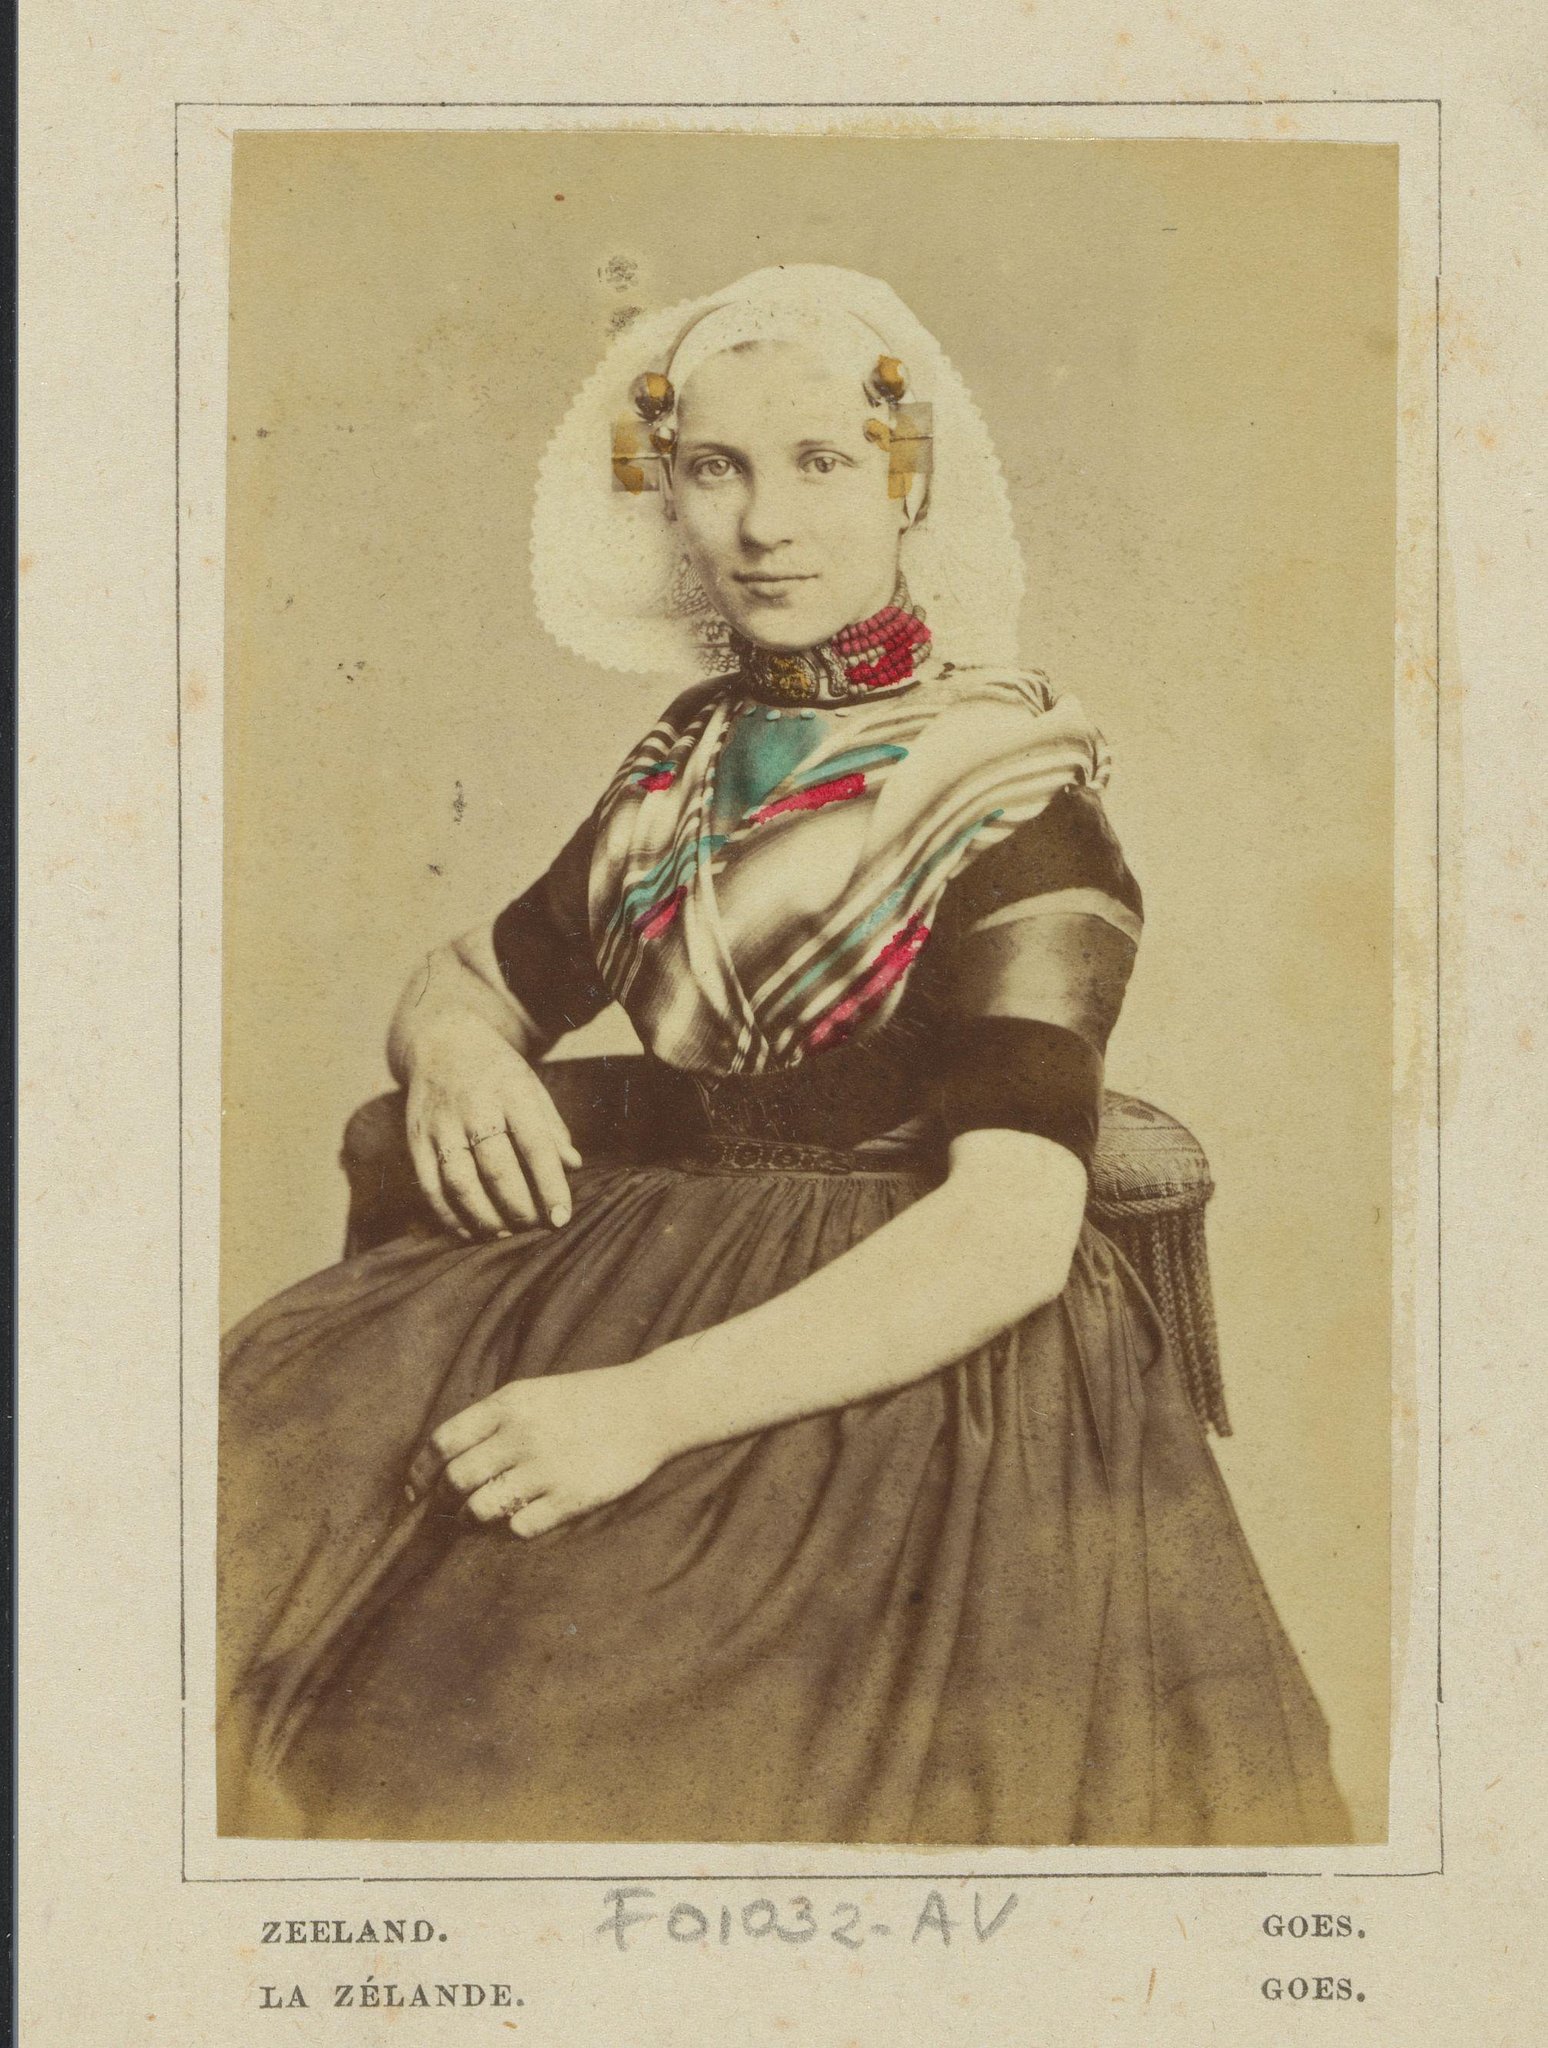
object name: photograph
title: Zeeland. Goes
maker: andries jager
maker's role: publisher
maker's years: 1825-1905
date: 1860-1890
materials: cardboard, photographic support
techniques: albumen print, hand coloring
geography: amsterdam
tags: folk costume, regional costume (+ women's clothes), historical persons - bb - woman, europeans (with name), netherlands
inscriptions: inscription: ‘Uitgave van A. JAGER, Water 110 te Amsterdam.’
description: Deze foto maakt deel uit van een omslag met 48 foto's op 12 bladen.